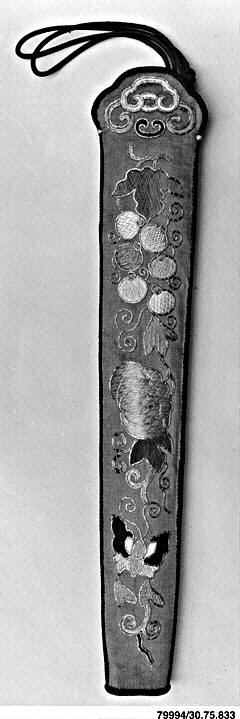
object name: fan holder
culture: chinese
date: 1701-1900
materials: metal thread, silk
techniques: embroidery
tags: butterflies